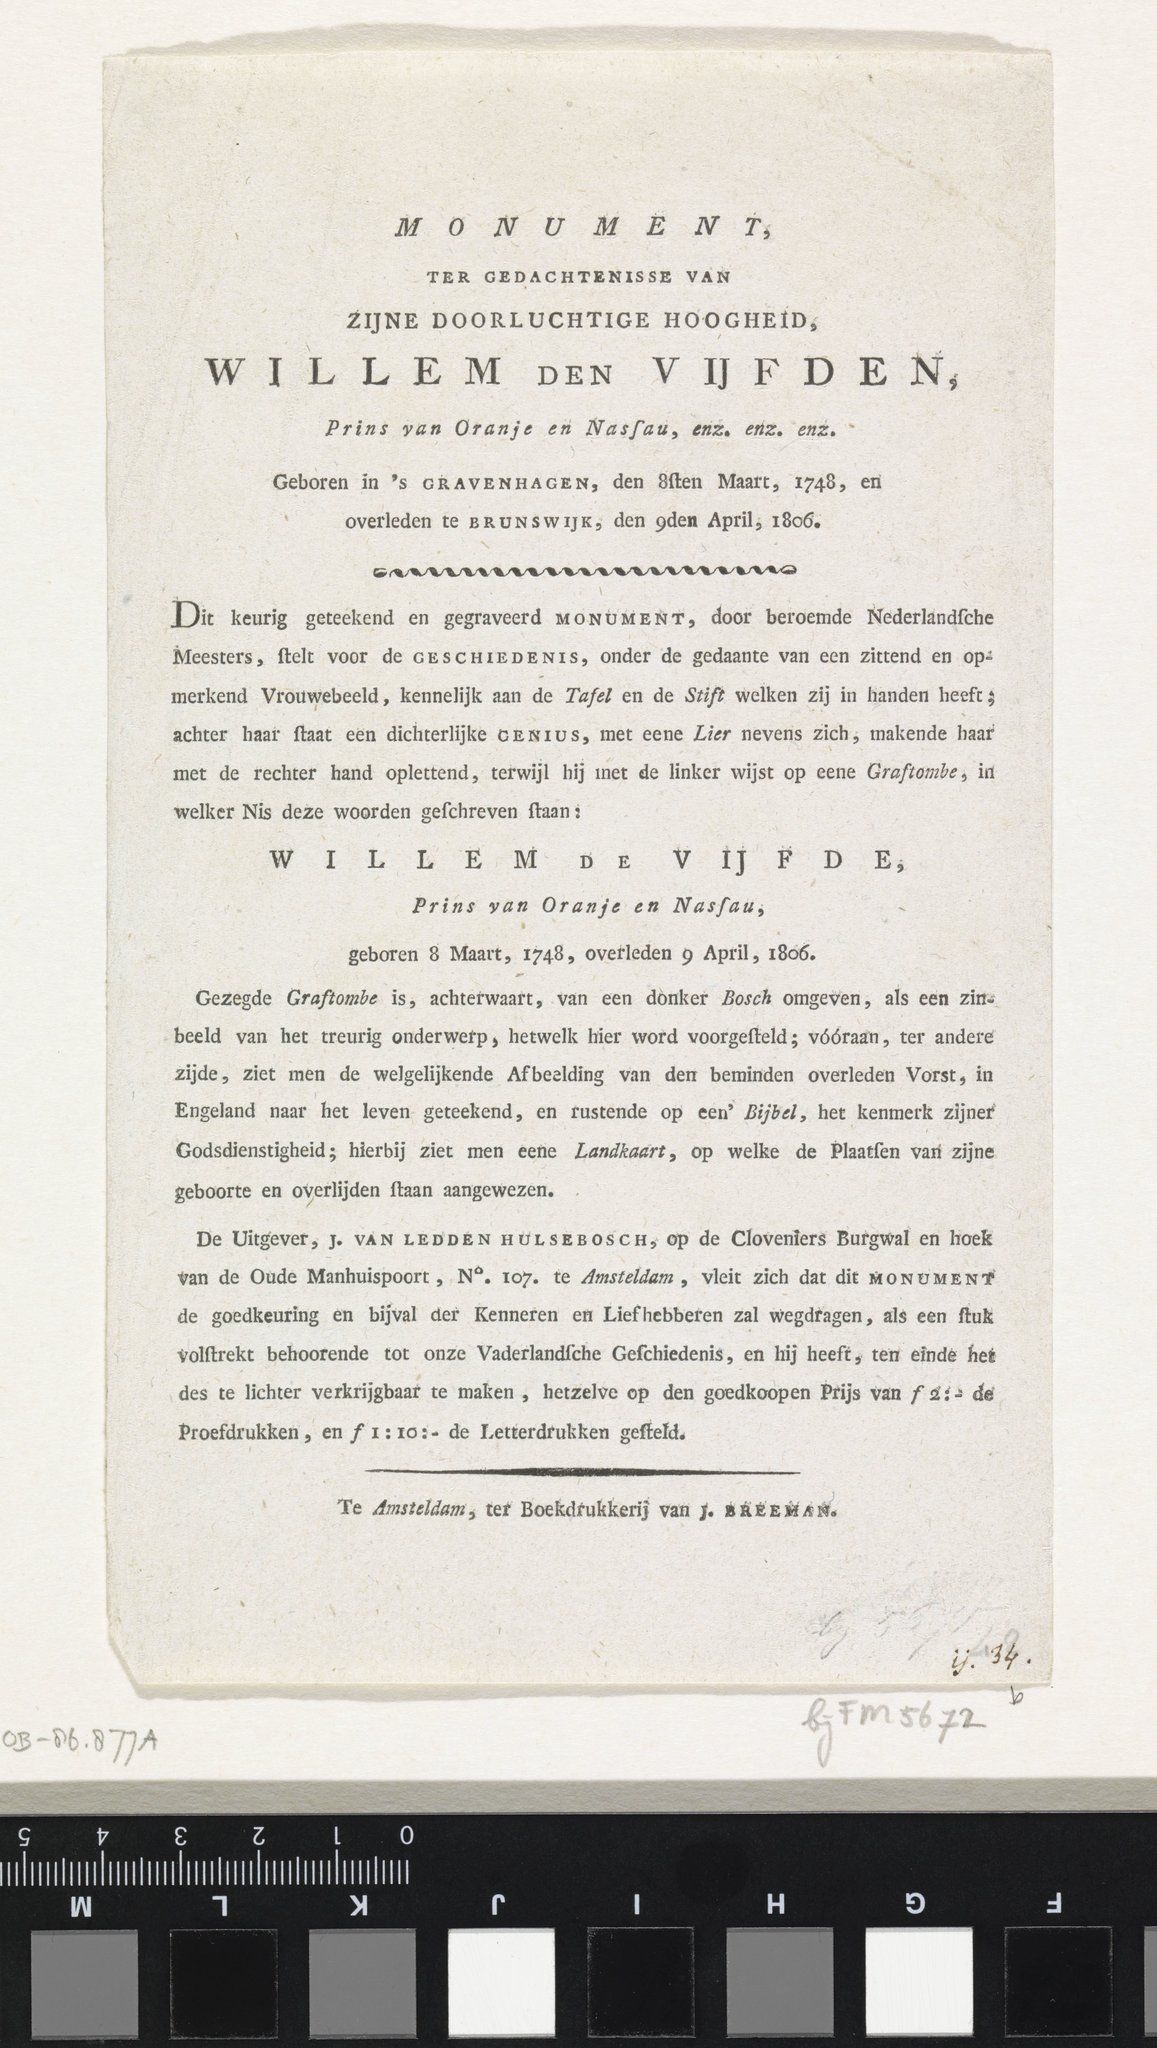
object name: text sheet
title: Monument ter gedachtenis van zijn doorluchtige hoogheid Willem den Vijfden (...)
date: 1806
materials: paper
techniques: letterpress printing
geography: amsterdam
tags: william v (prince of orange)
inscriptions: collector's mark: Lugt 2228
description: Verklaring behorend bij de prent met het allegorische grafmonument voor prins Willem V, overleden op 9 april 1806. Gedrukte tekstblad met een uitleg van de voorstelling en wat de prijzen voor verschillende drukken zijn bij de uitgever Van Ledden Hulsebosch.